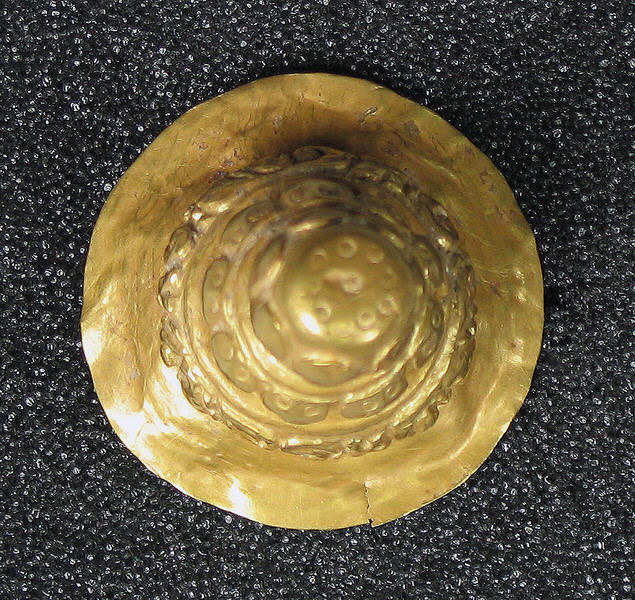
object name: hair ornament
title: Hair Oornament, Three Buns, Lotus Decoration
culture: indonesian, central java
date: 701-1200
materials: gold